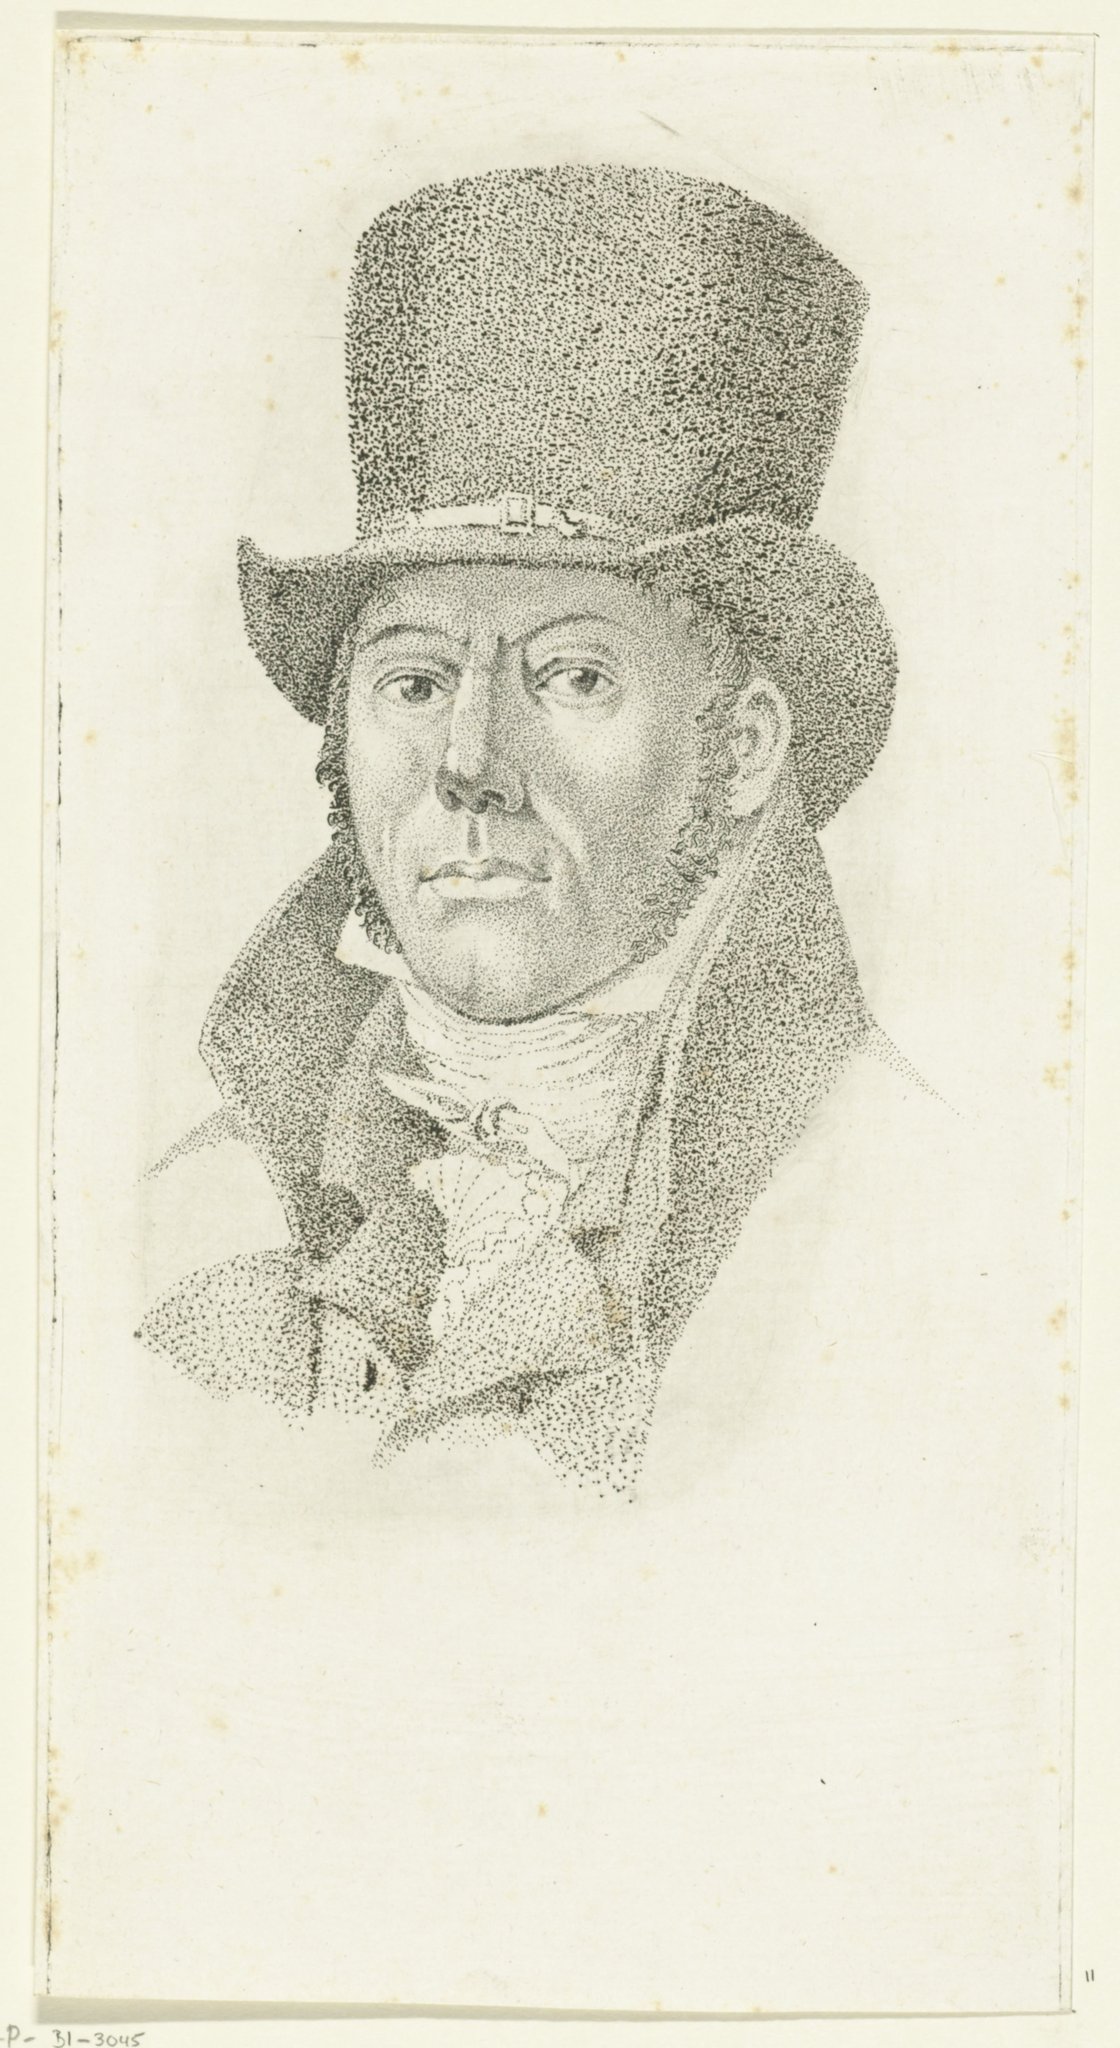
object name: print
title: Portret van Jacob Ernst Marcus met hoge hoed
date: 1805-1838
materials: paper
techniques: aquatint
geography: netherlands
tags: jacob ernst marcus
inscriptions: collector's mark: Lugt 2228